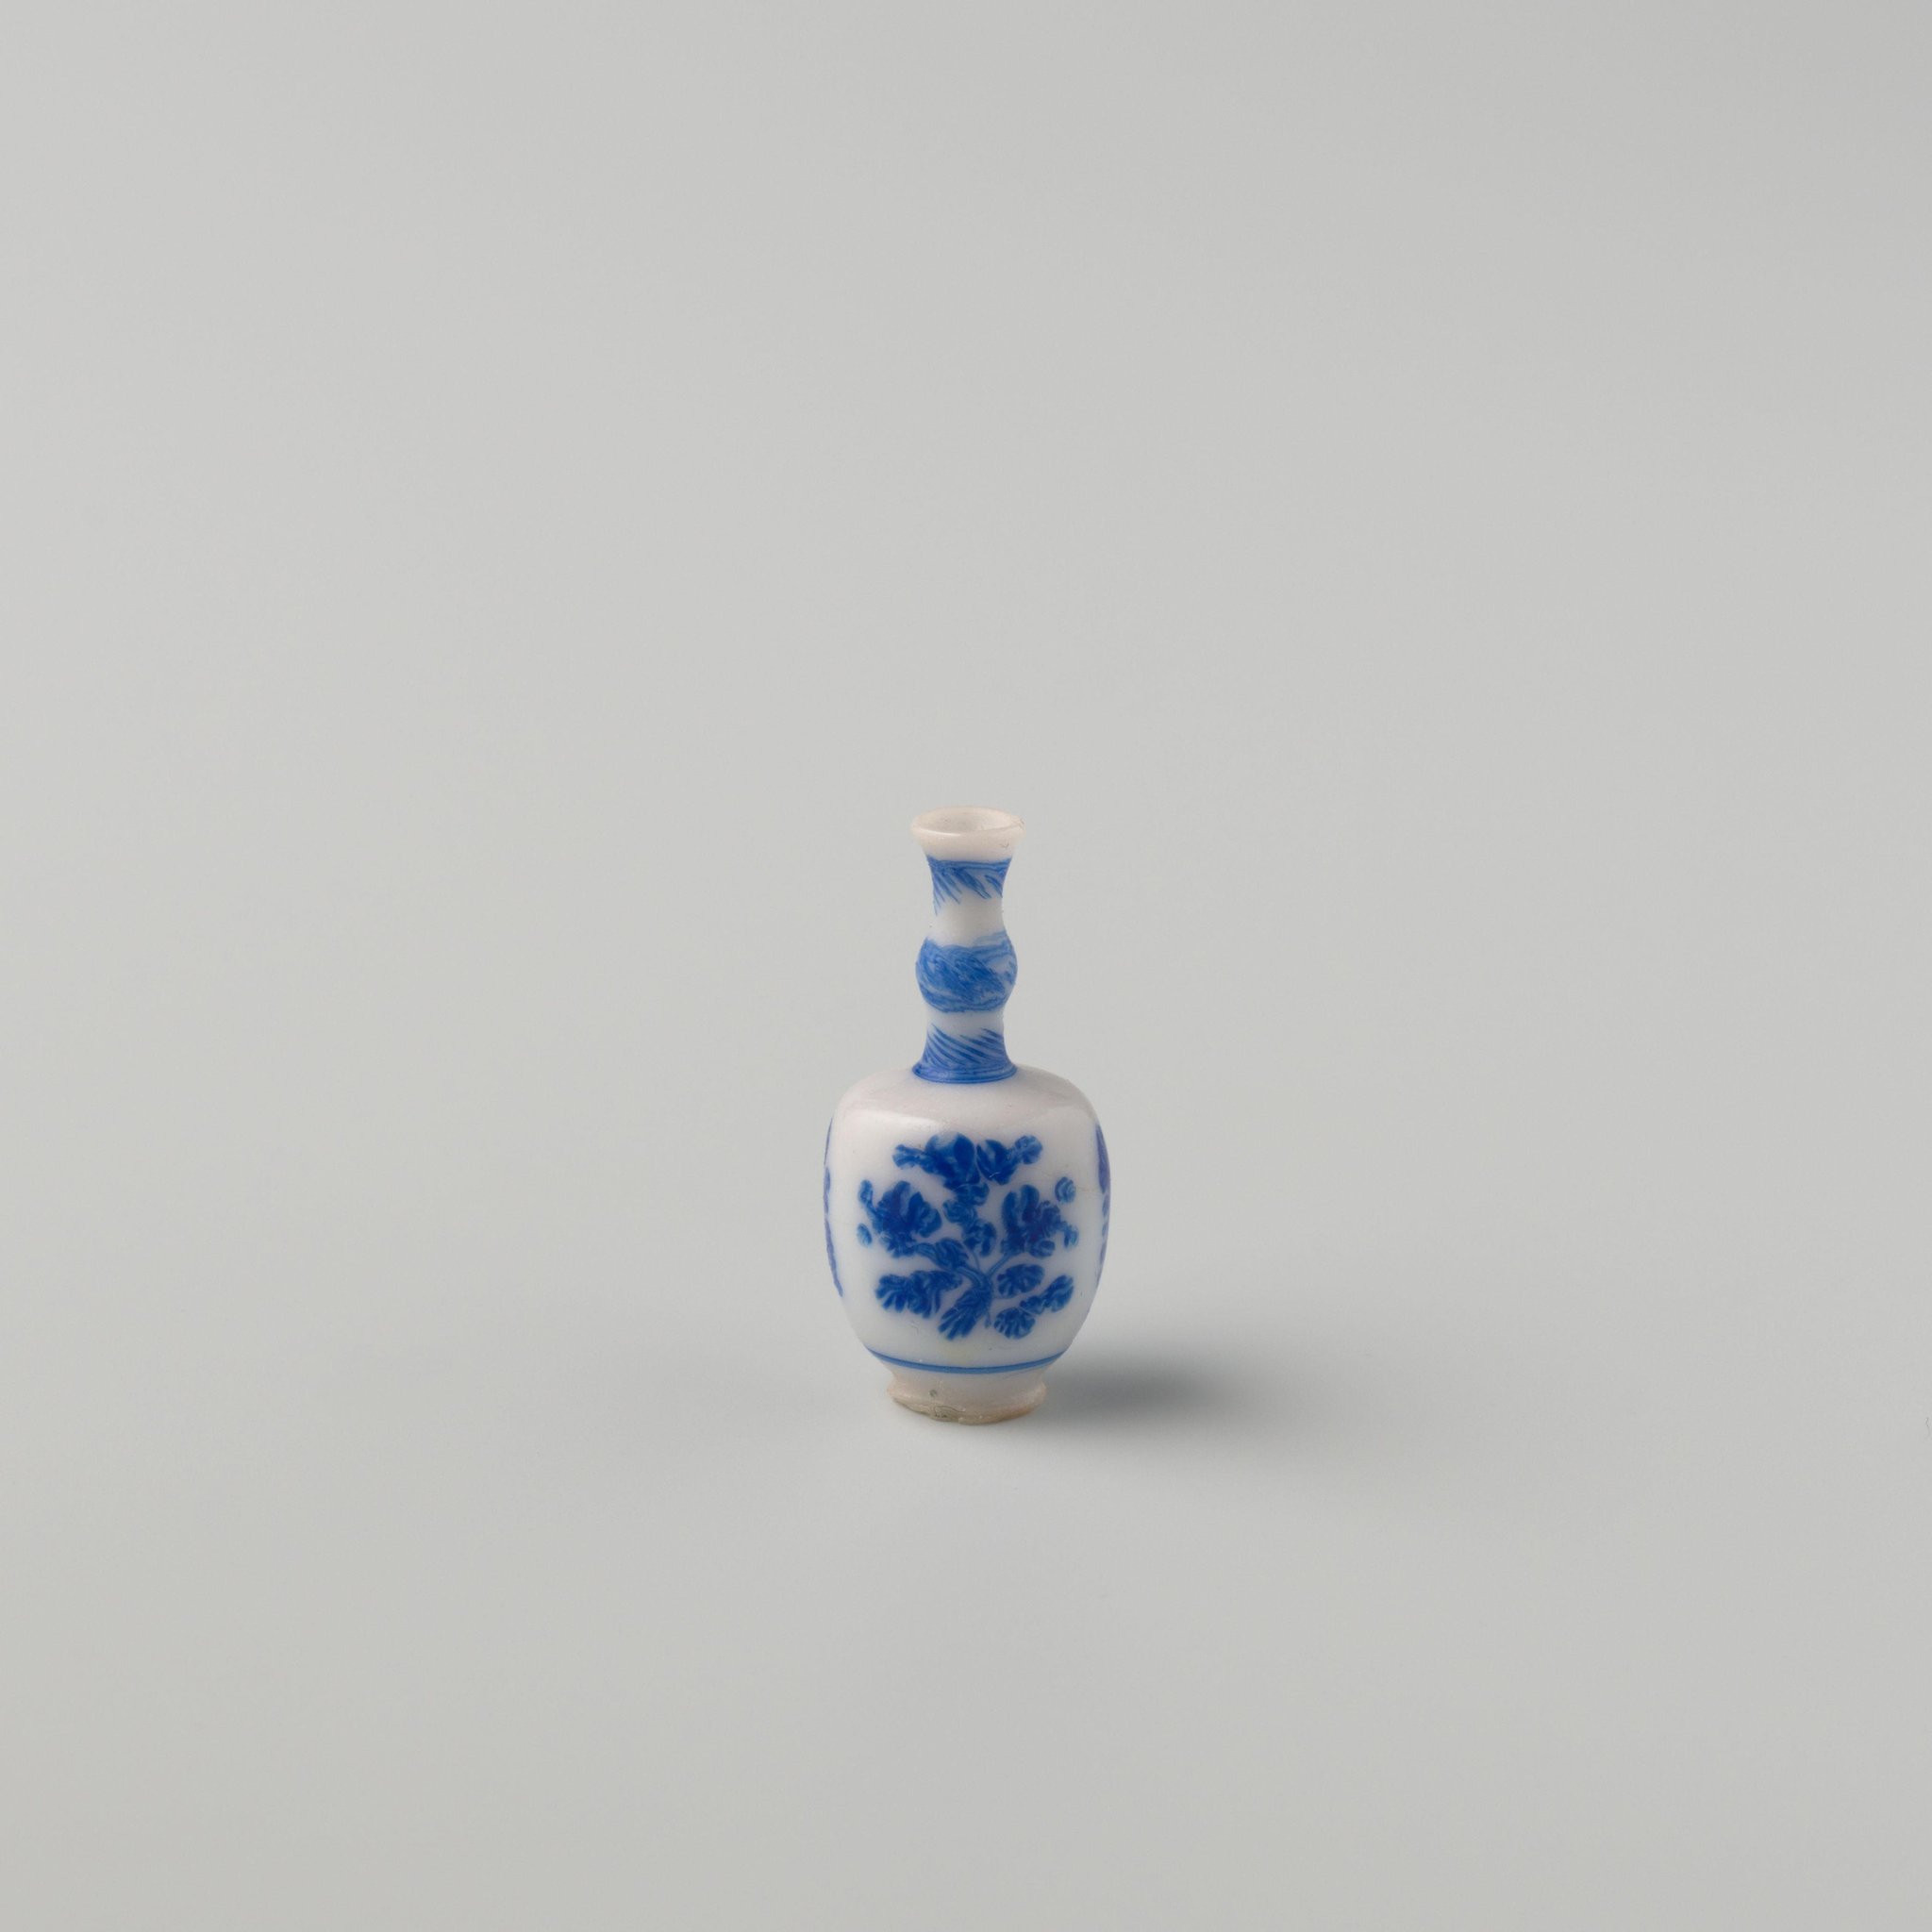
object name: miniature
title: Fles van melkglas met blauwe emailverf beschildering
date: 1675-1700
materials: glass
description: Fles van melkglas met blauwe emailverf beschildering, imitatie Chinees blauw porselein; model met afgeplakt, bolvormige buik waarop twee bloemtuilen en slanke hals met verdikking, versierd met streepjes. Op standring.